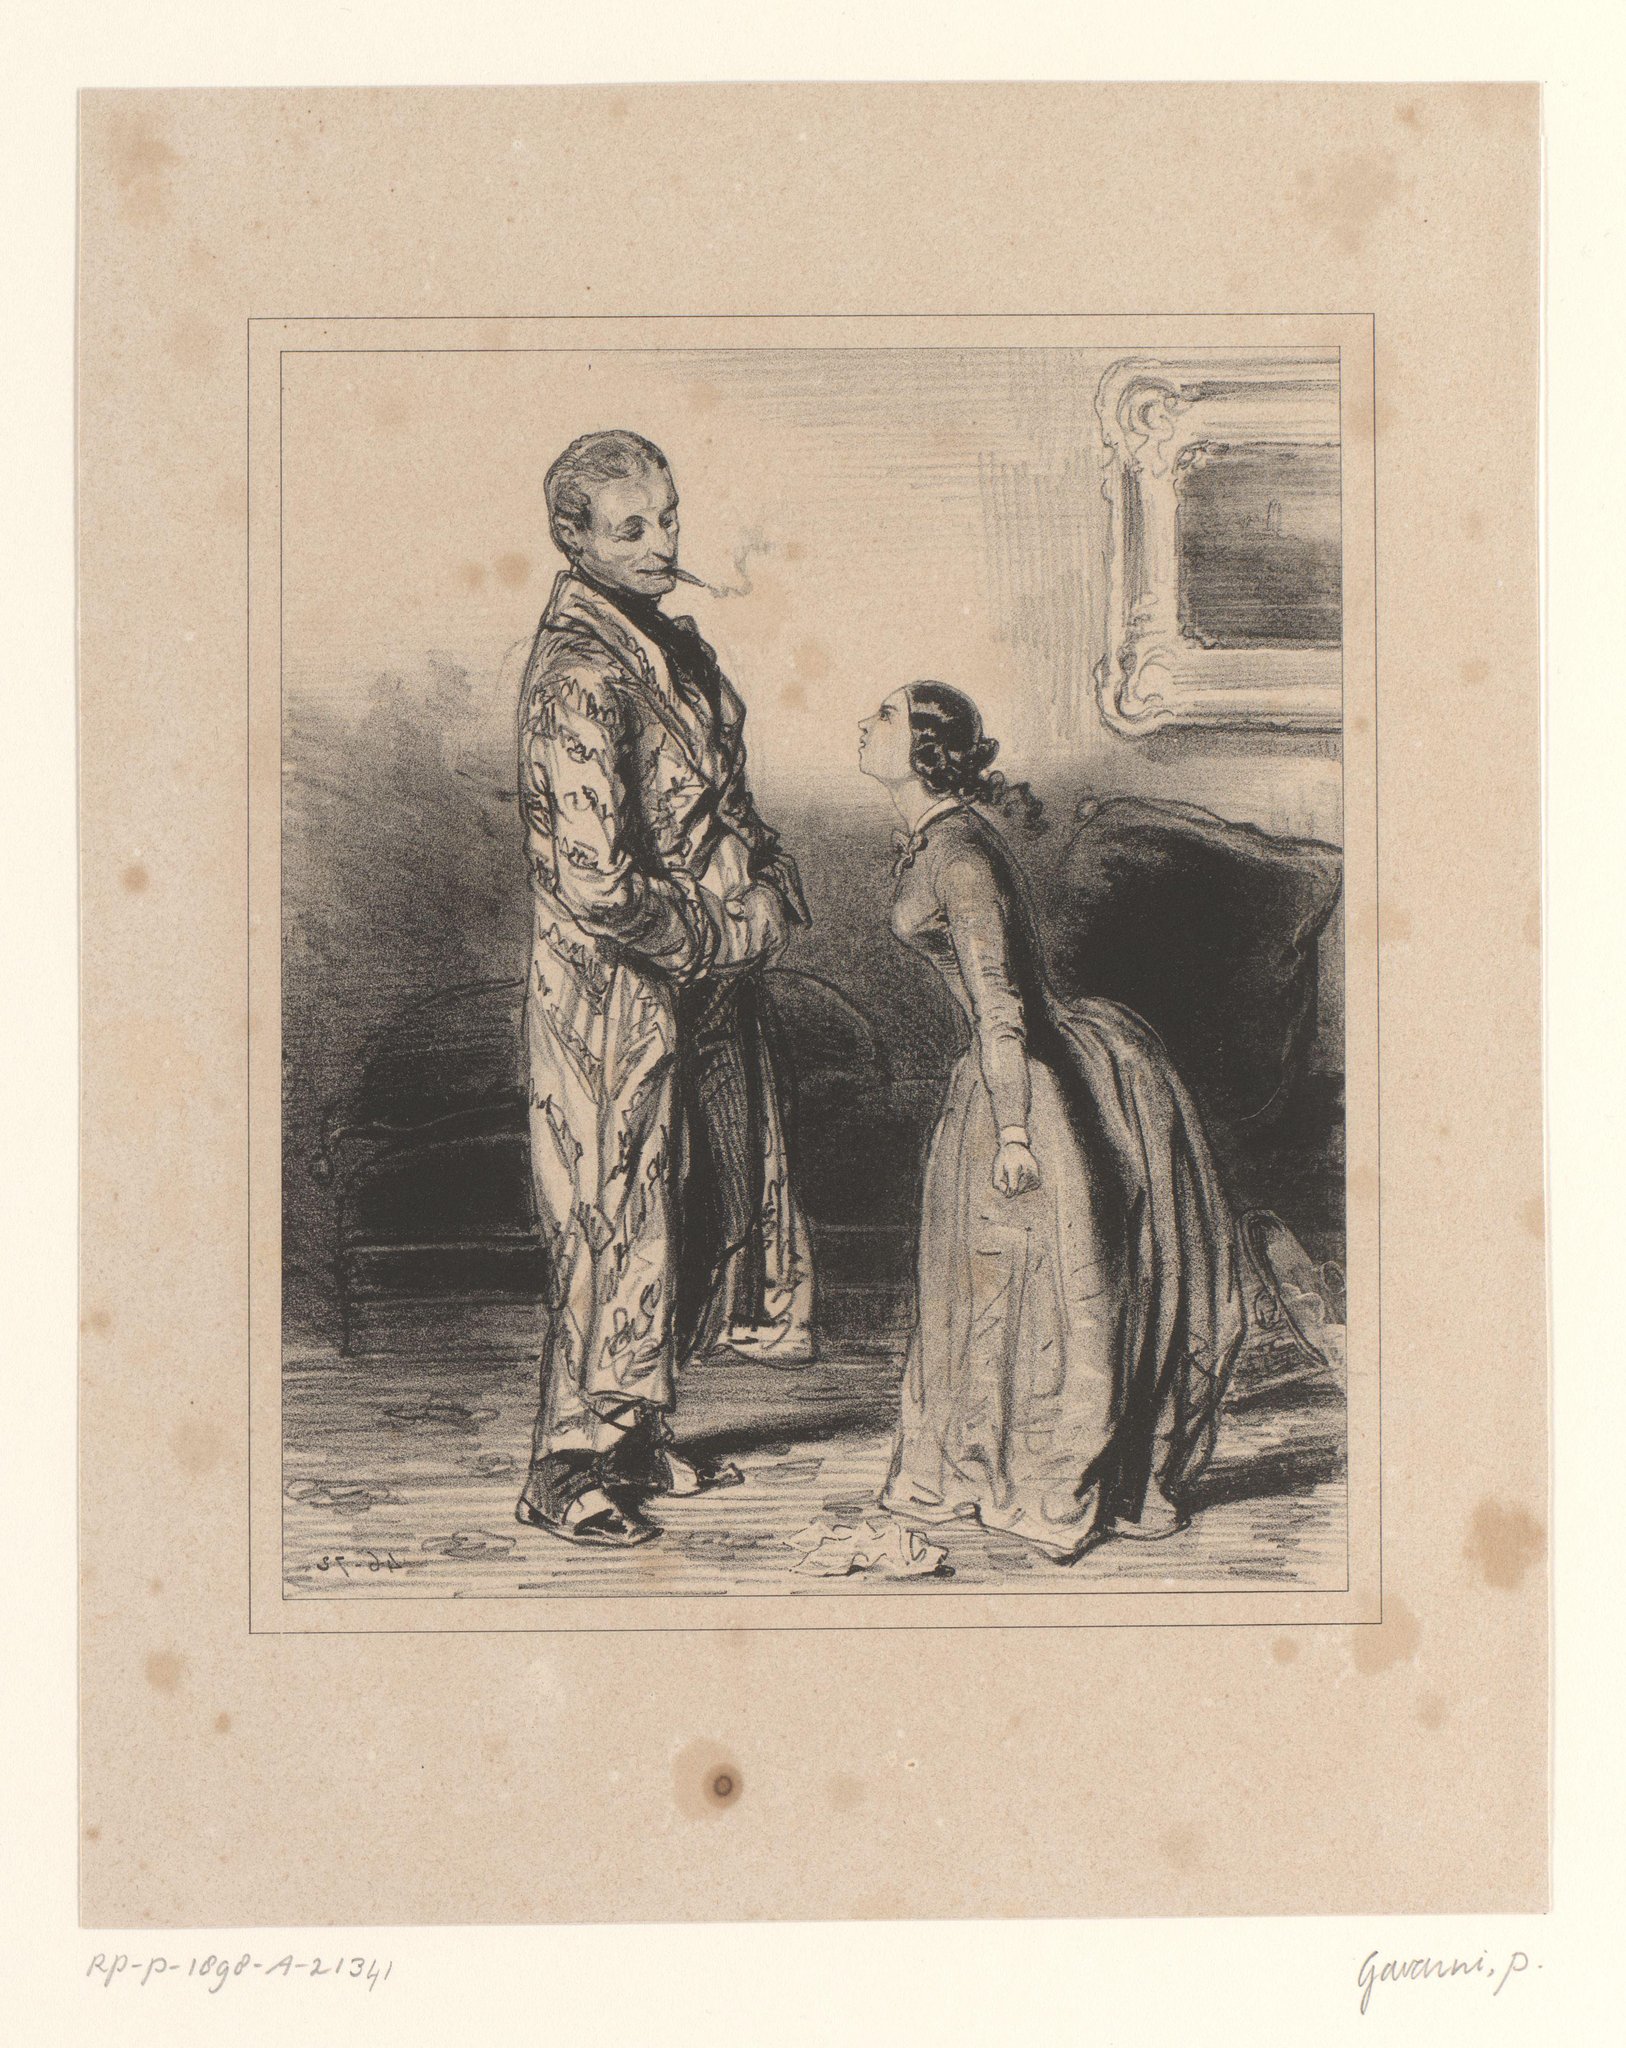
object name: print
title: Impressies van het huwelijk (2)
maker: paul gavarni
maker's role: draughtsman, print maker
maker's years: 1804-1866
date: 1847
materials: paper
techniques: lithograph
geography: paris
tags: cigar, man and wife quarrelling, 'marriage à la mode', satire on marriage, bath-robe, dressing-gown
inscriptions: collector's mark: Lugt 964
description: Terwijl de vrouw haar vuisten balt, blijft de man rustig staan en rookt hij een sigaar.